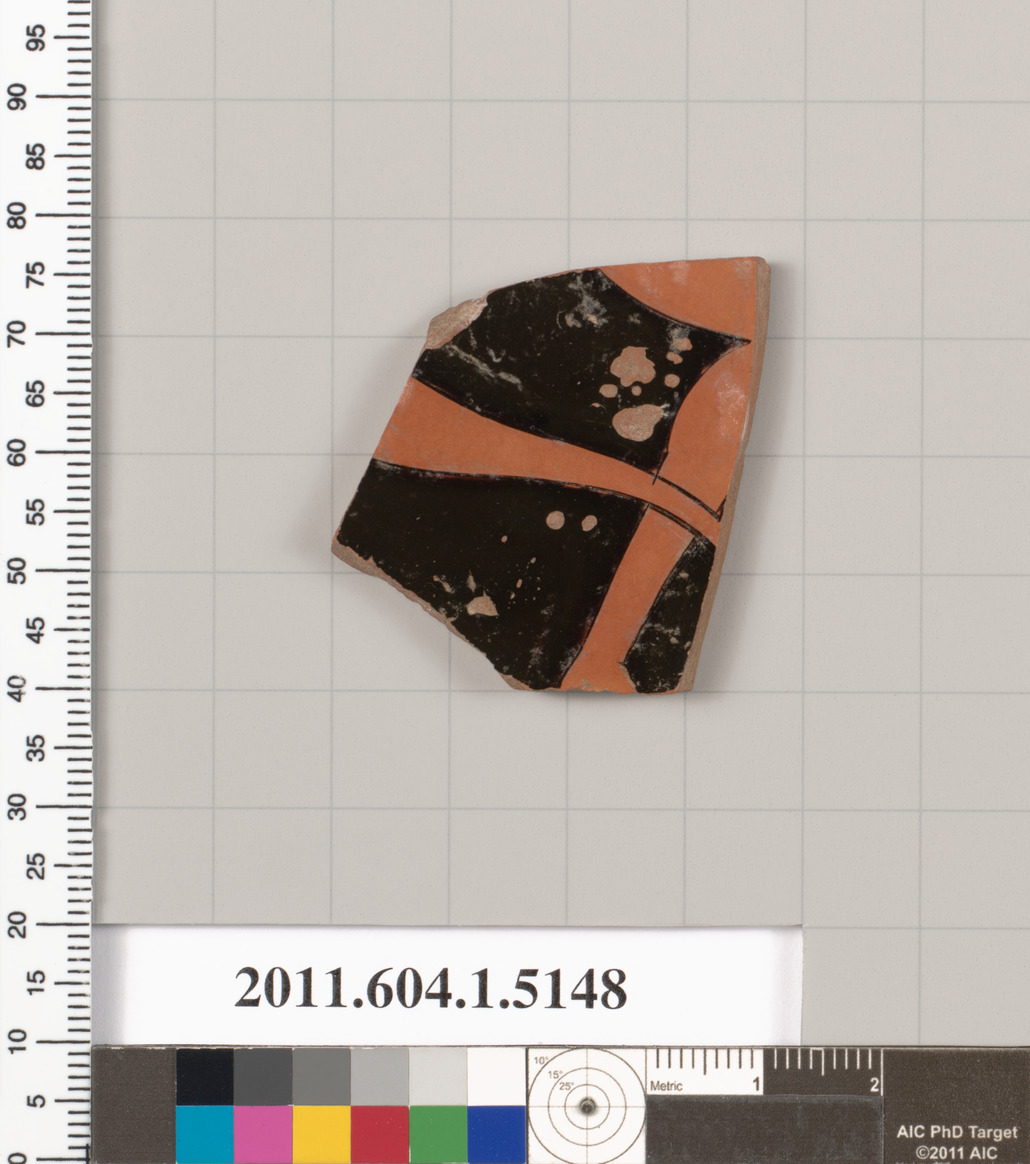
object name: kylix fragment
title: Terracotta fragment of a kylix (drinking cup)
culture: greek, attic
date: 500-480 BCE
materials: terracotta